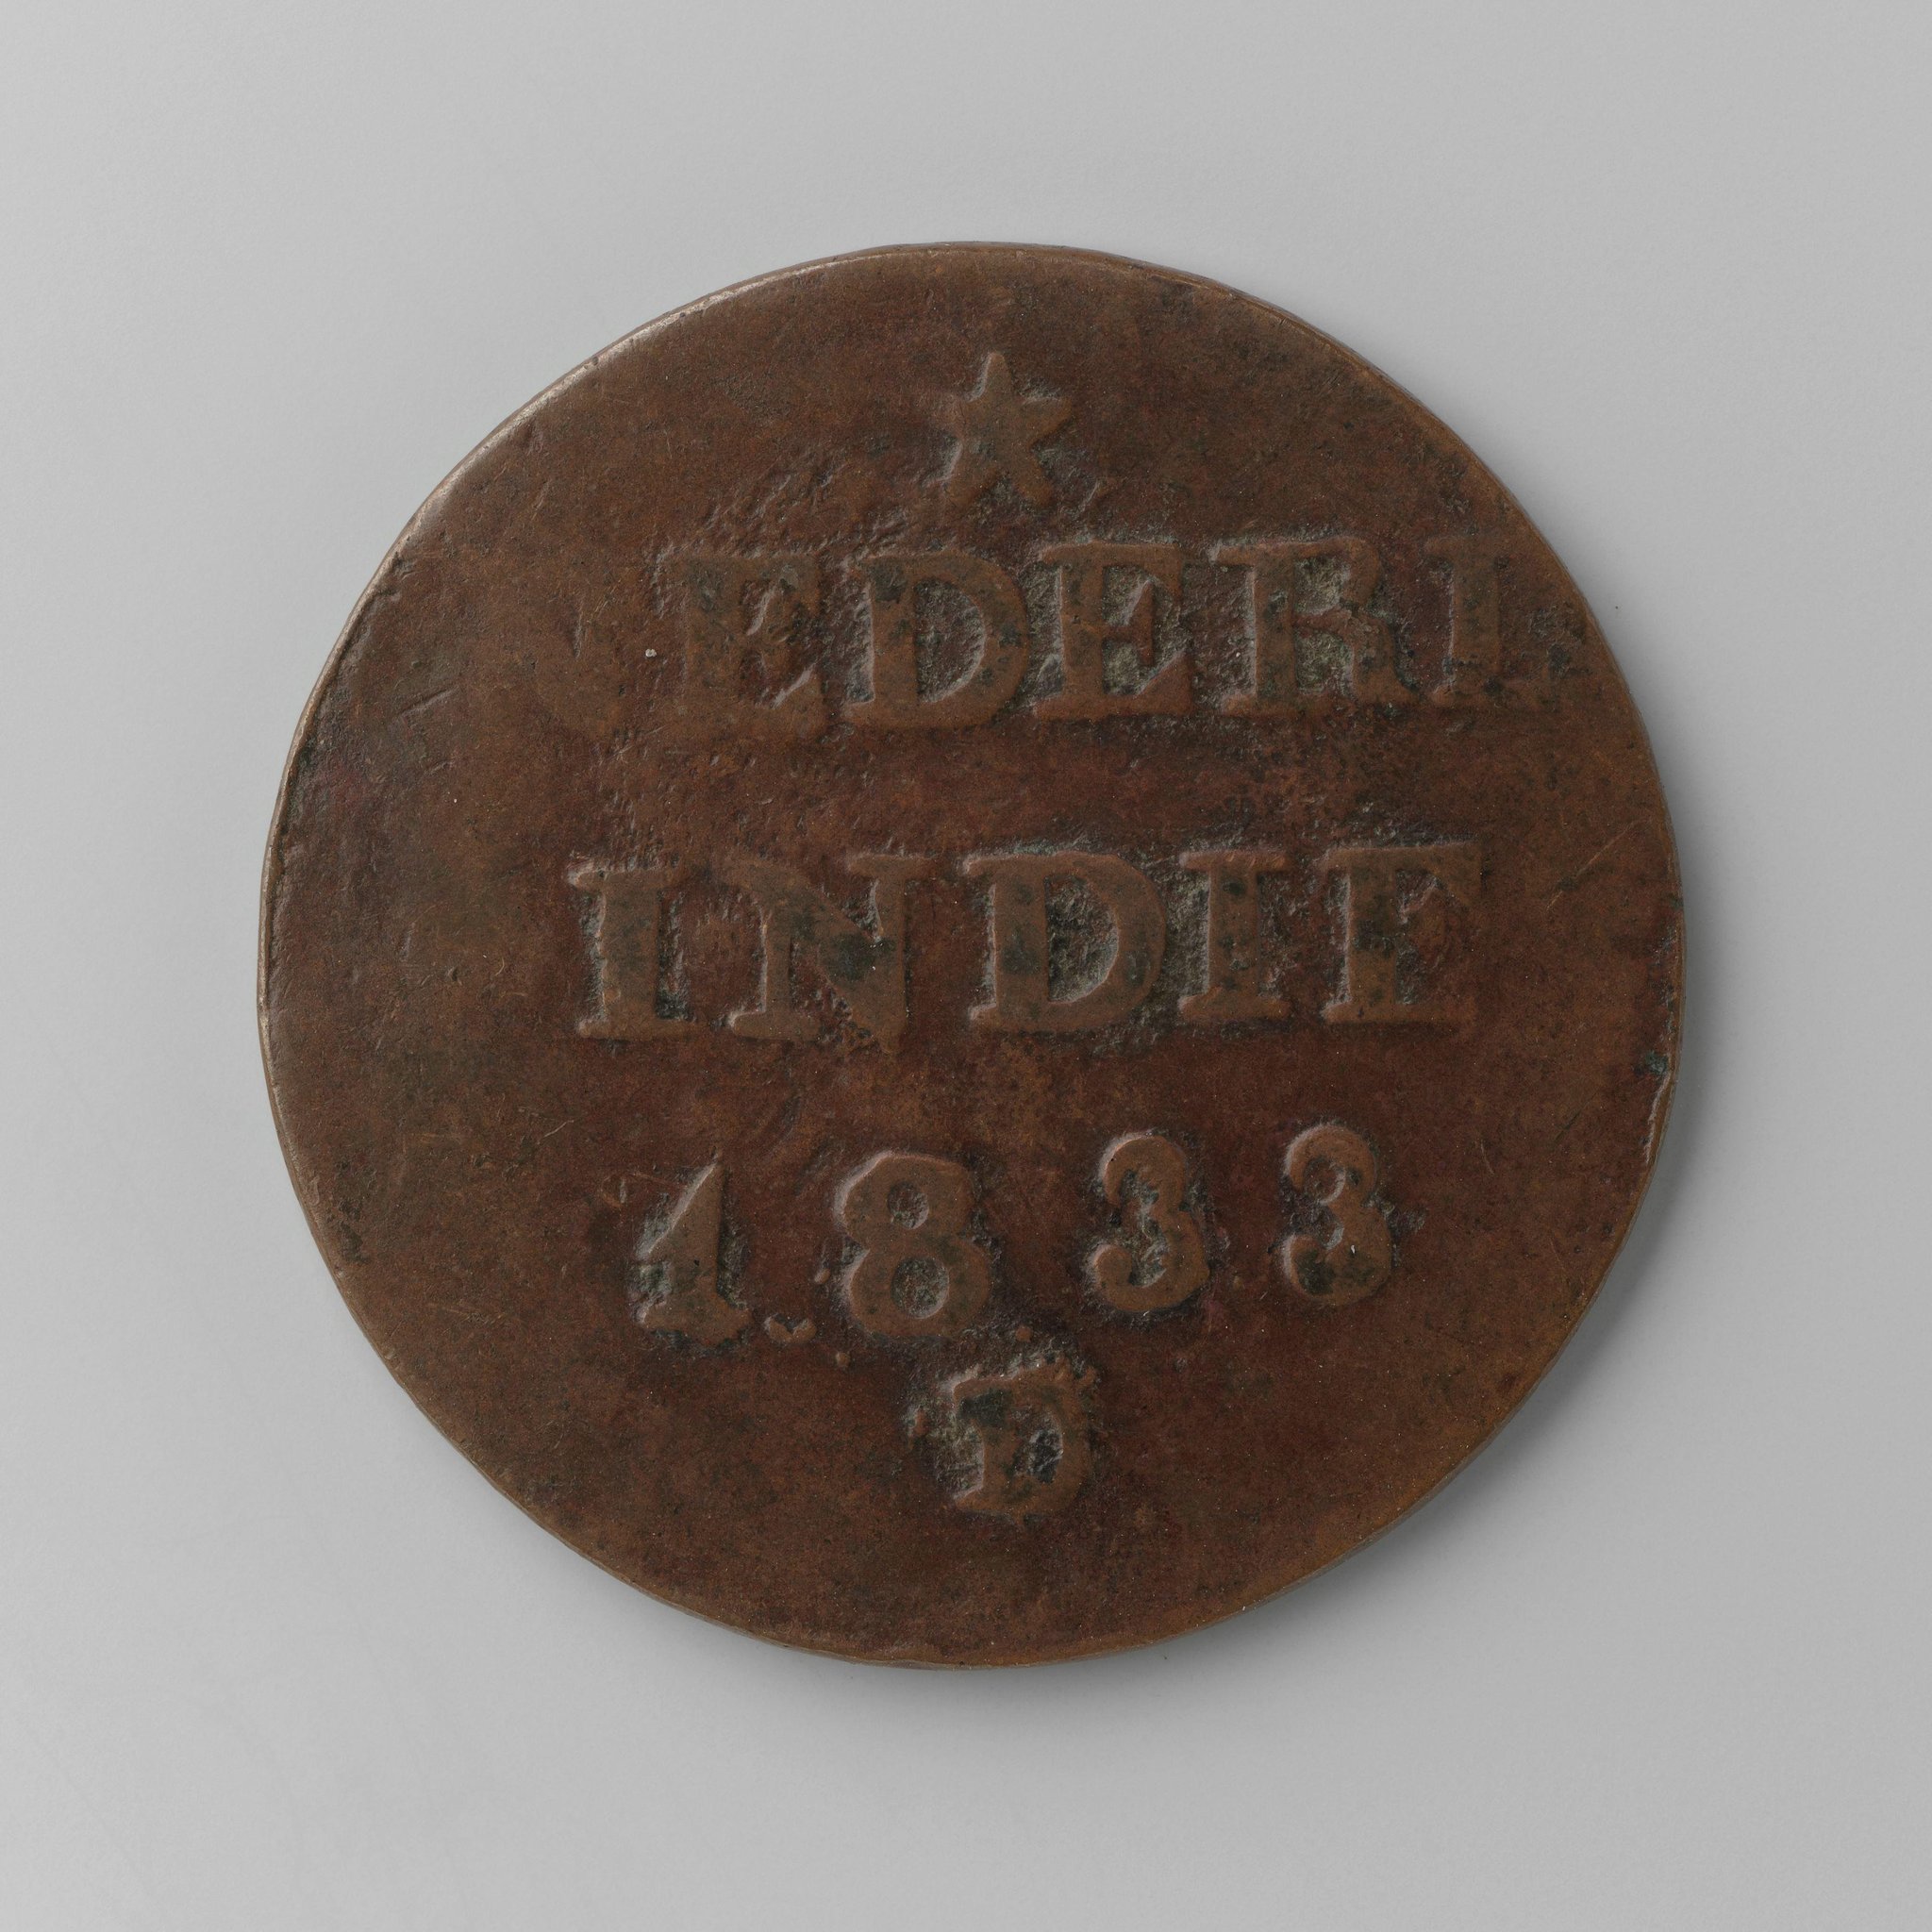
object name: coin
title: Nederlands Indië, 2 cent,1833 D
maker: william i of the netherlands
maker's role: koning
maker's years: 1772-1843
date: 1833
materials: copper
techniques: striking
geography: surabaya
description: Koperen munt. Voorzijde: tussen waarde-aanduiding 2 CT. gekroond rijkswapenschild. Keerzijde: tweeregelig opschrift, waarboven muntteken en waaronder jaartal. Daaronder letter D [=muntmeester Demmenie]. Gladde rand.